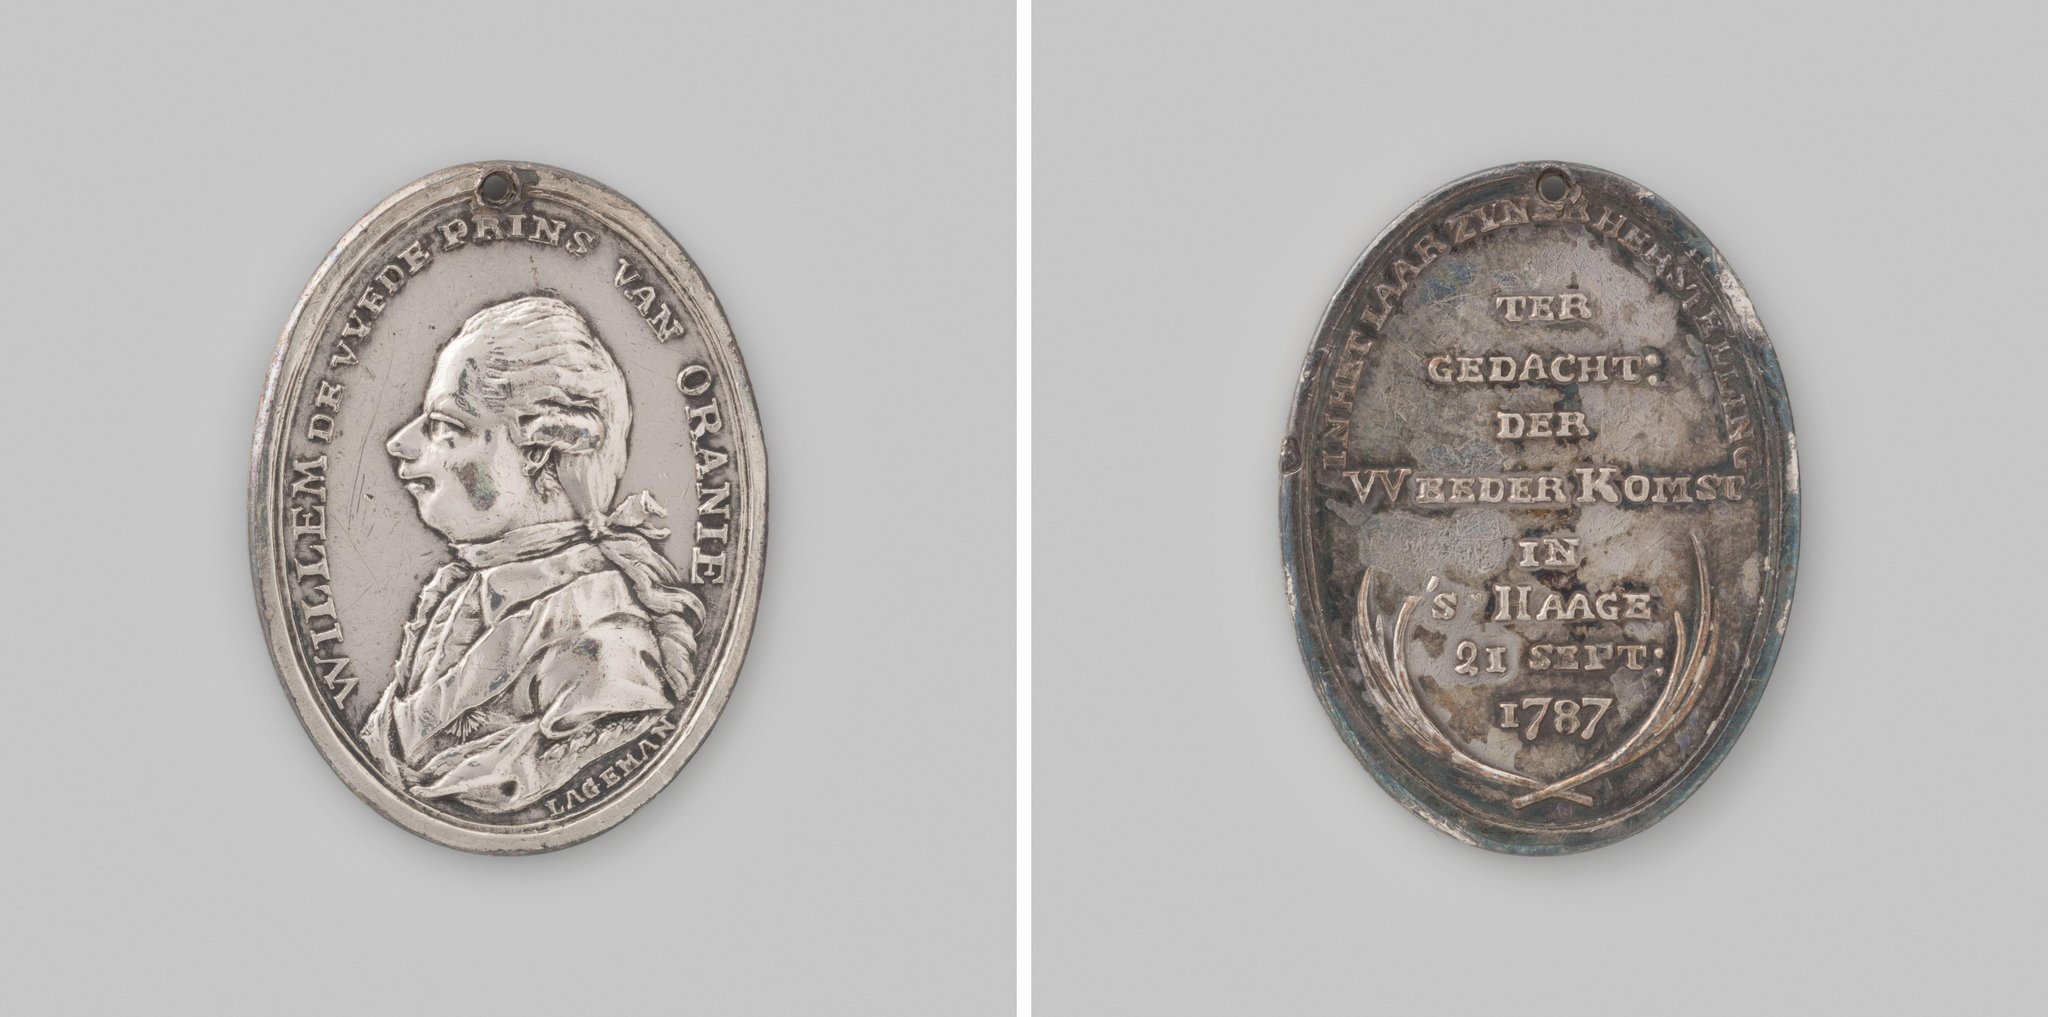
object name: history medal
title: Herstel van Willem V als erfstadhouder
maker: johannes michiel lageman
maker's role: silversmith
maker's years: 1735-1809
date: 1787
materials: silver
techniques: striking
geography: amsterdam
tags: the hague, william v (prince of orange)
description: Zilveren ovale penning met gat erin. Voorzijde: borststuk man binnen omschrift. Keerzijde: opschrift boven twee samengebonden palmtakken binnen omschrift